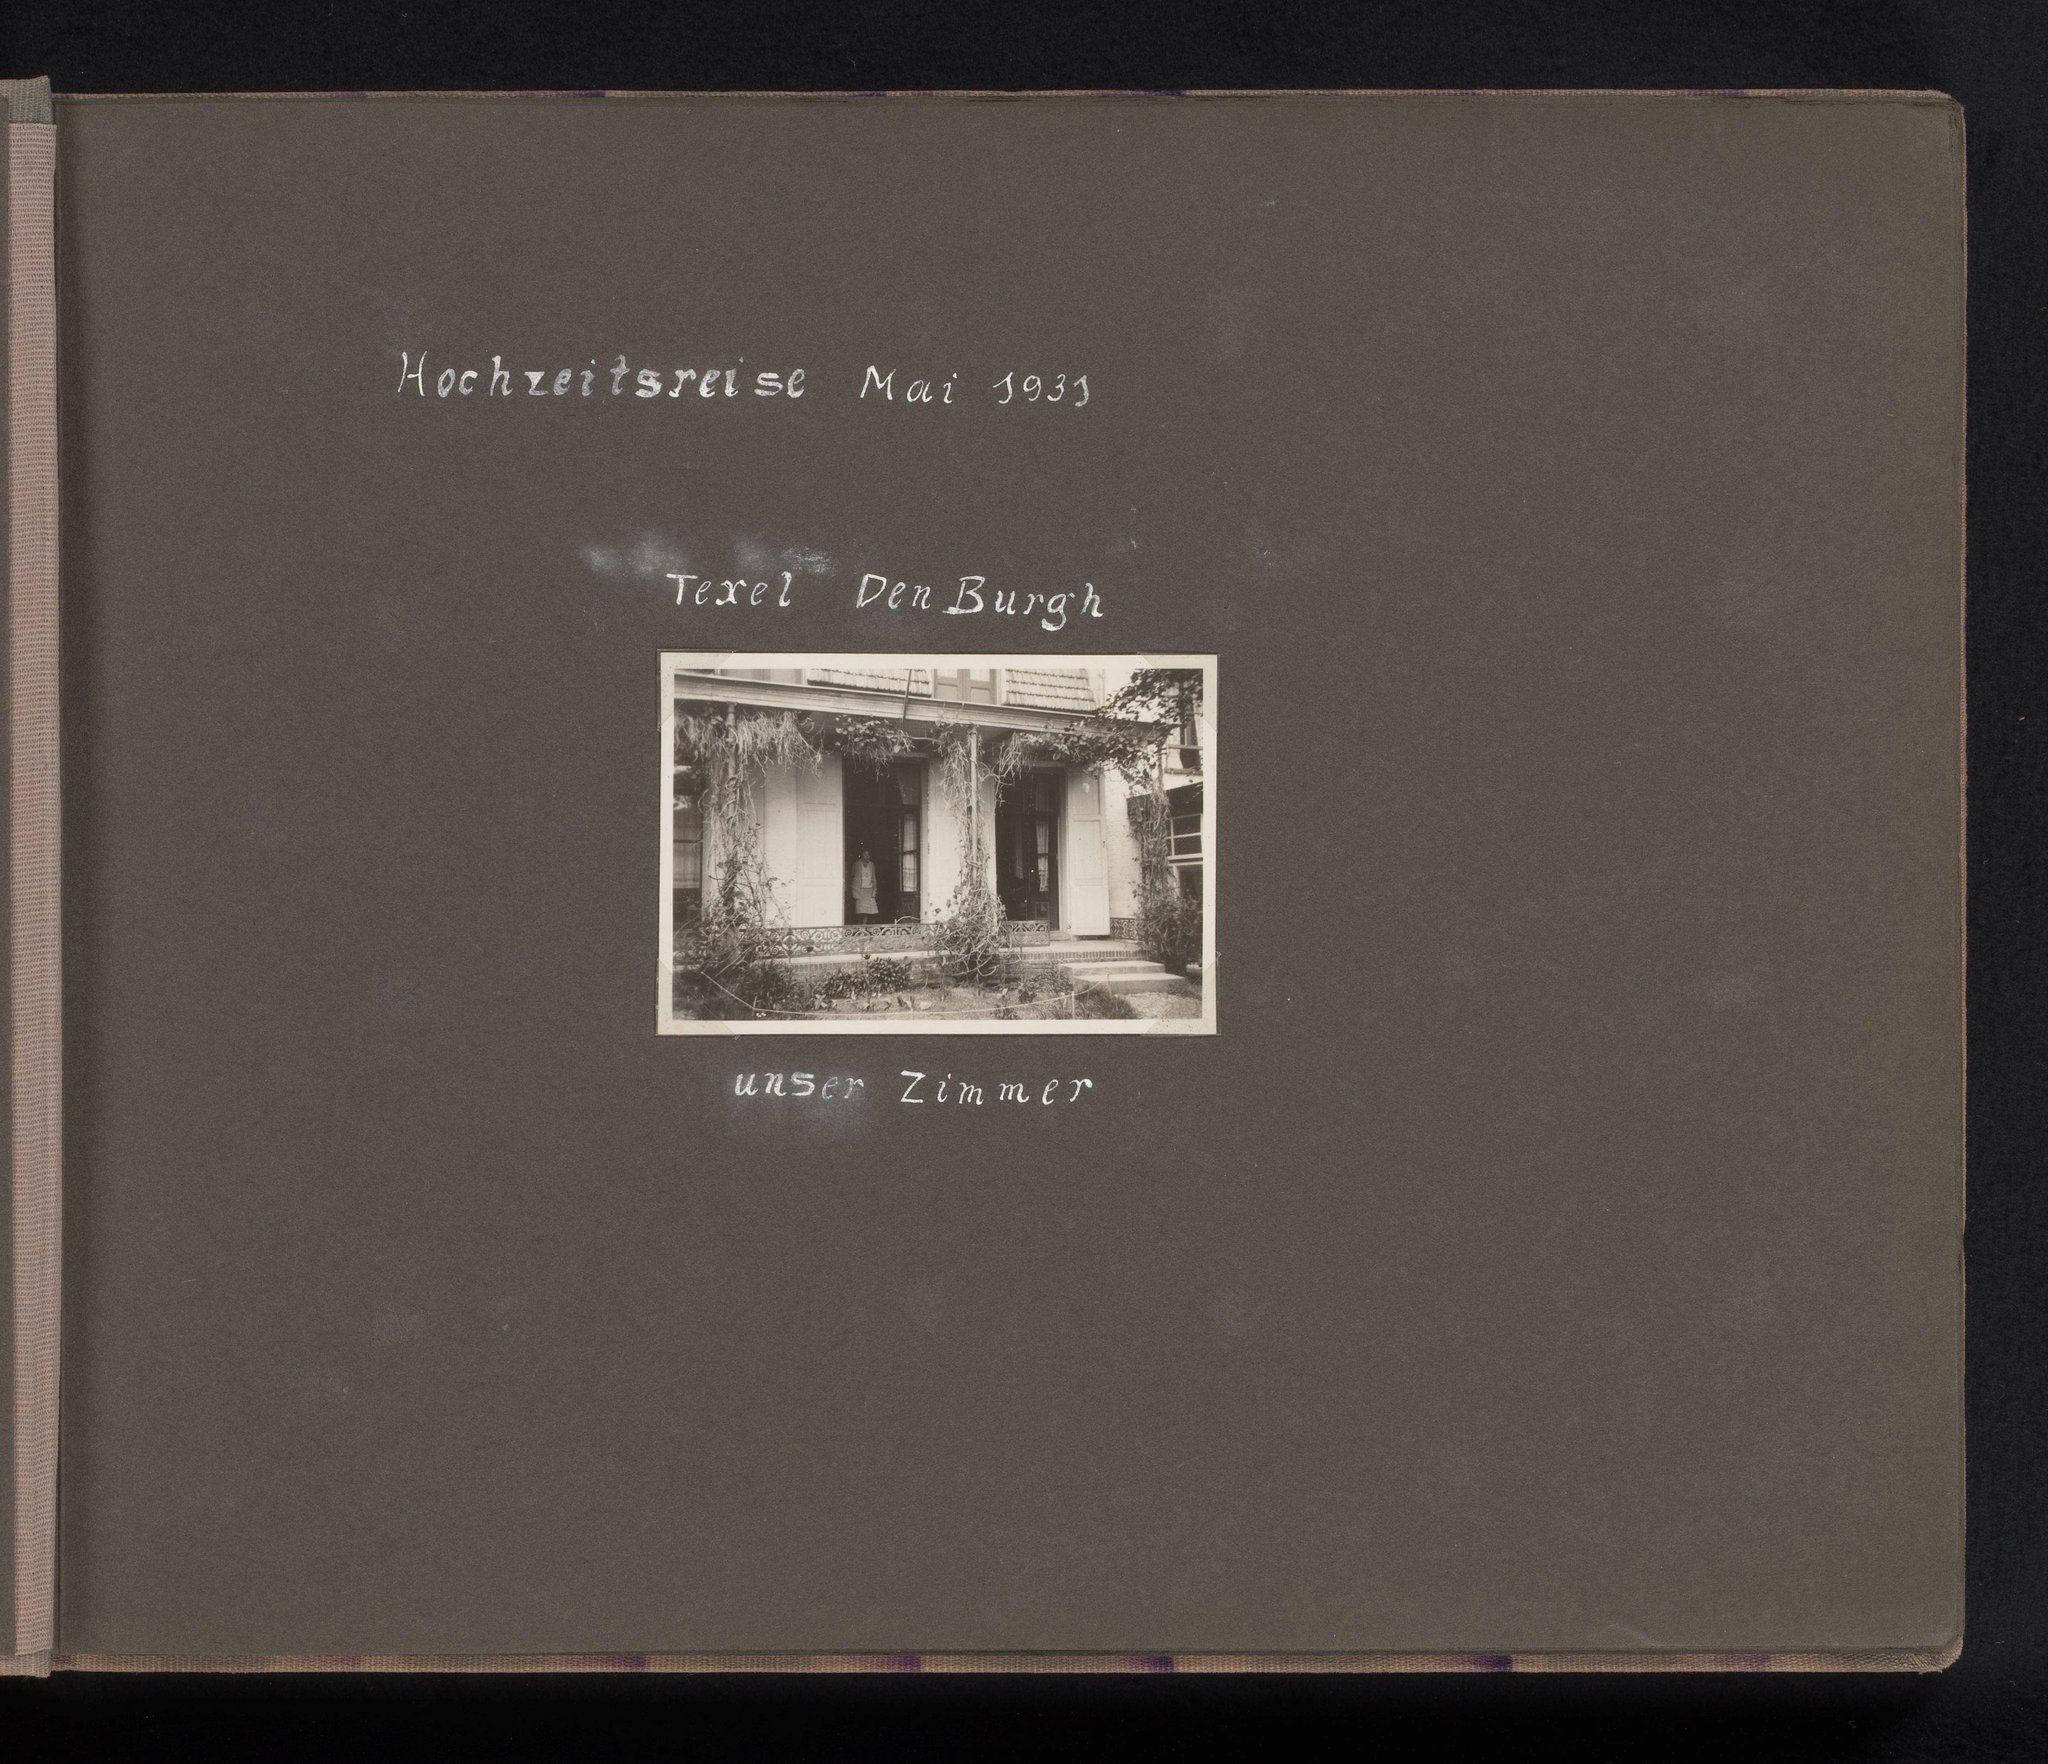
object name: photograph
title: Berti Hoppe in een verblijf op Texel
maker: herman besselaar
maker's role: taalkundige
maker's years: 1904-1994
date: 1905-1931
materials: cardboard, paper, photographic support, plastic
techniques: gelatin silver print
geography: texel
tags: historical persons - bb - woman, hotel, hostelry, inn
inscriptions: annotation: ‘Hochzeitsreise Mai 1931’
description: Deze foto is gemaakt tijdens de huwelijksreis van Berti Hoppe en Herman Besselaar. Deze pagina maakt deel uit van een album.